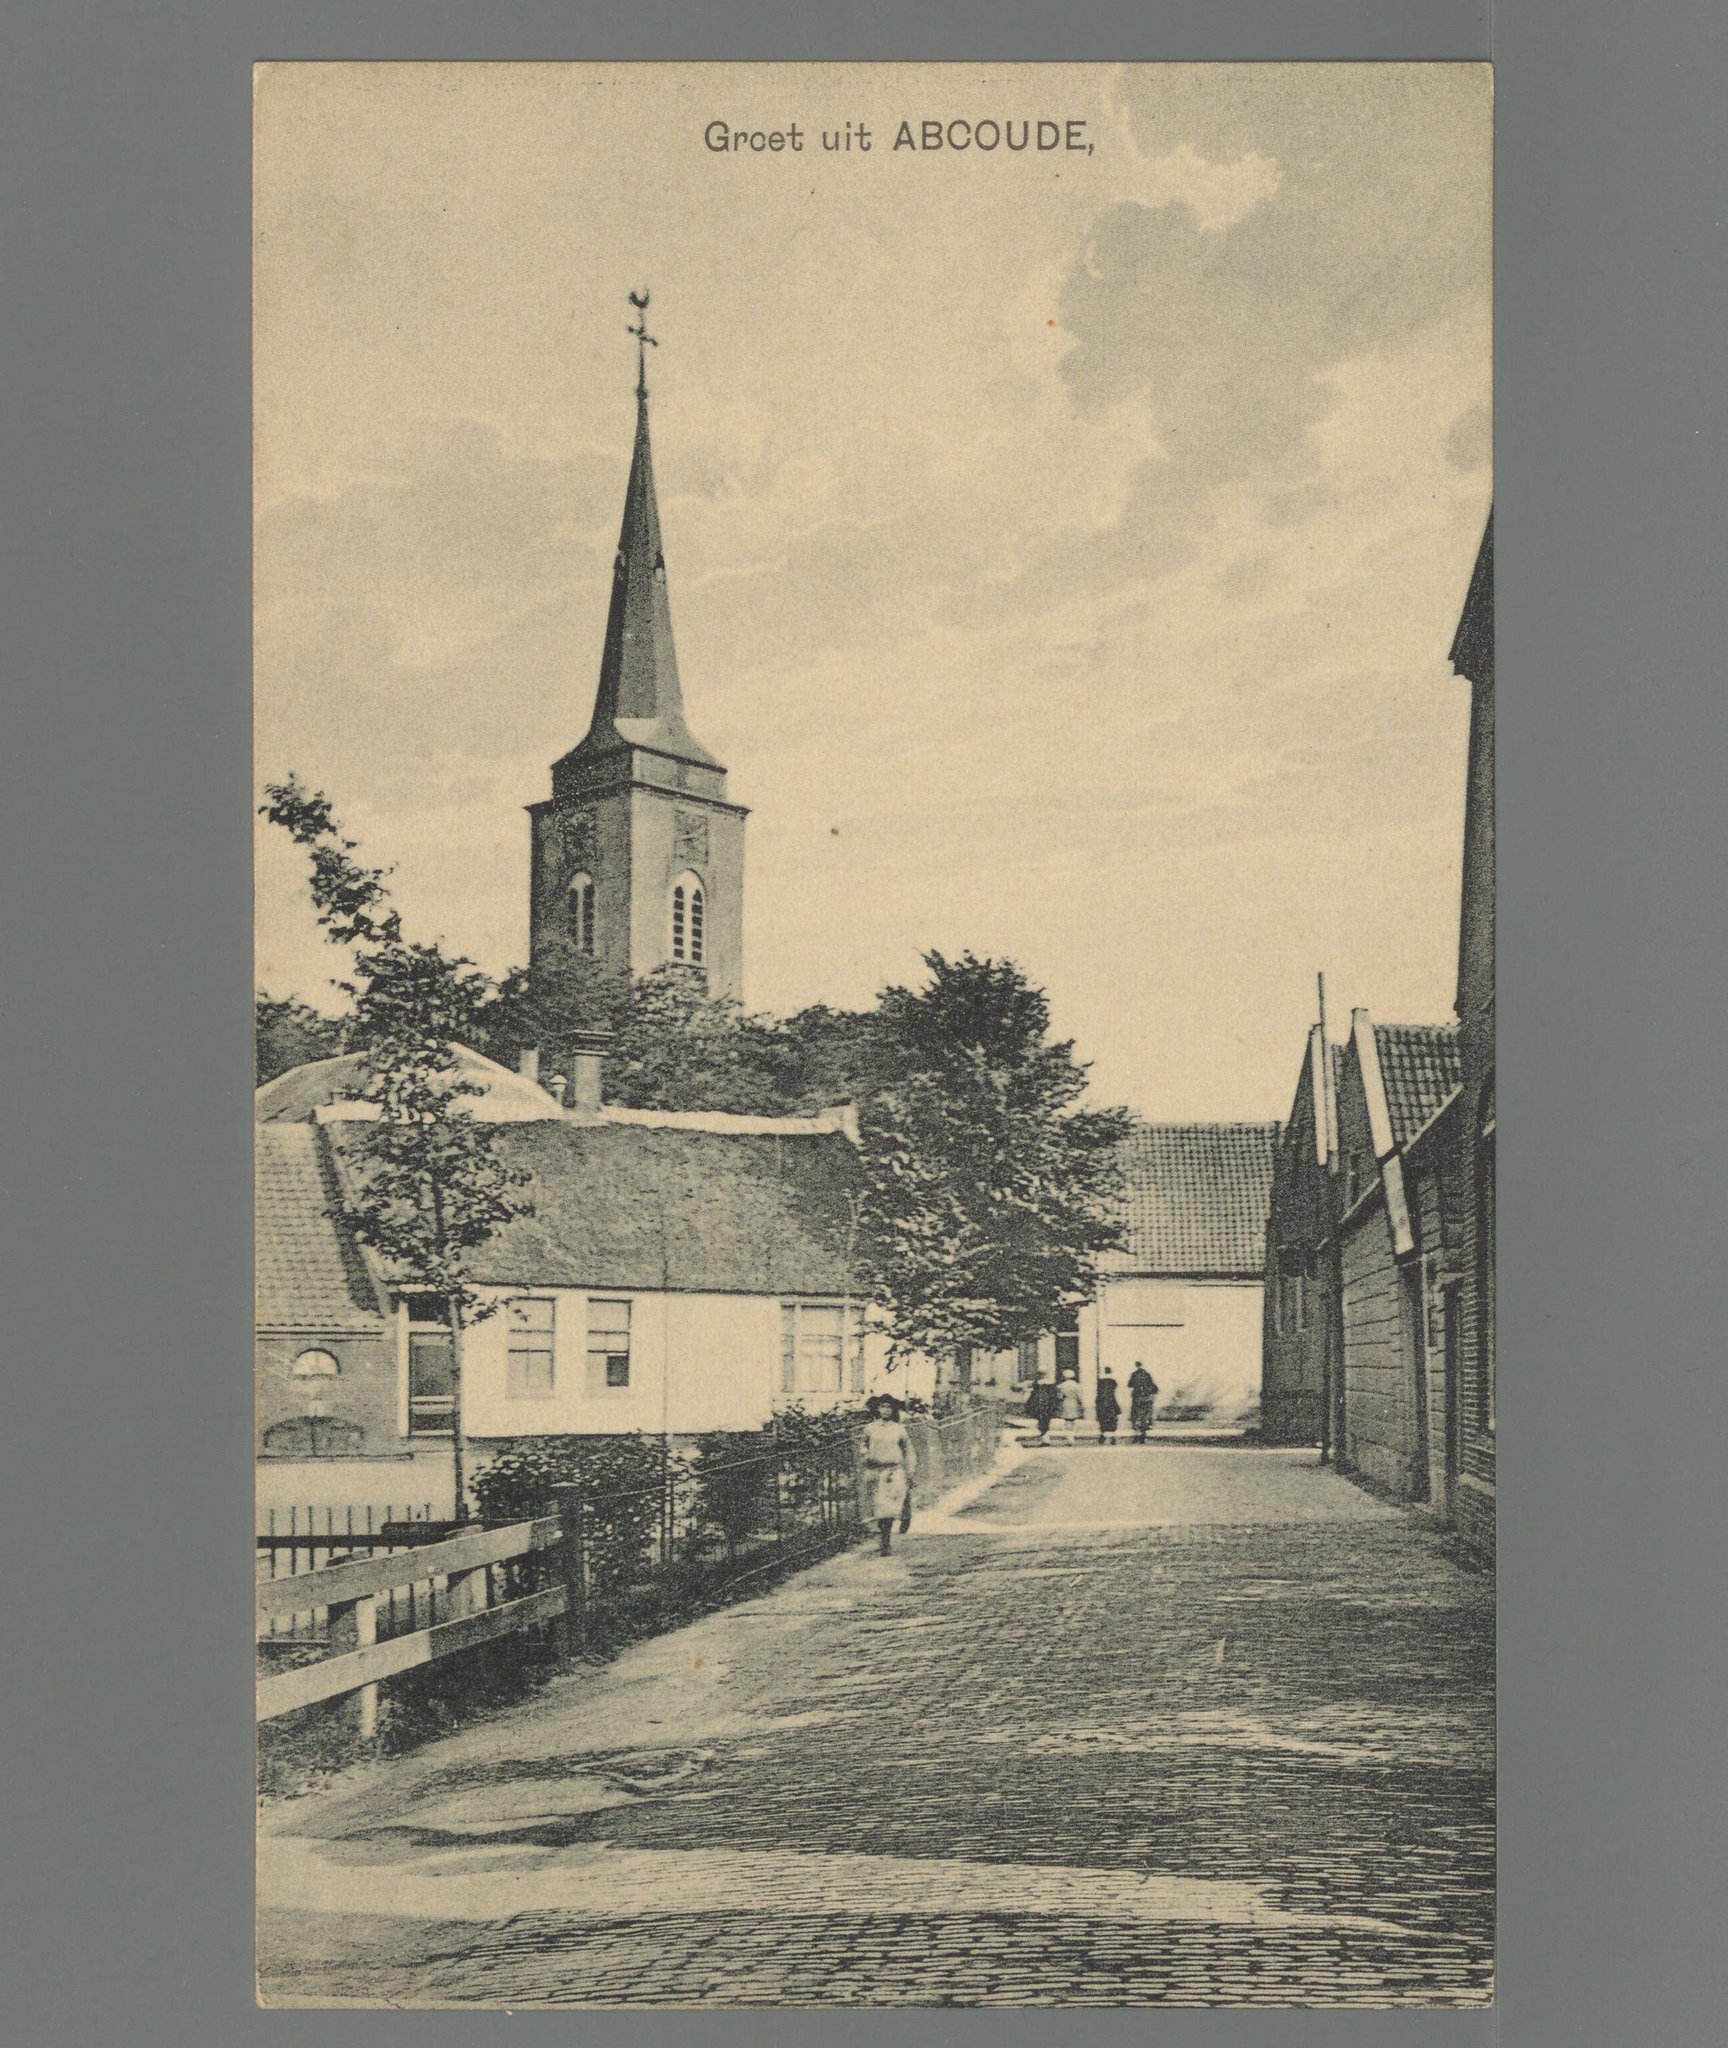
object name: photomechanical print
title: Groet uit ABCOUDE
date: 1906-1926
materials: cardboard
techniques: photograph, writing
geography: velsen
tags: city-view, and landscape with man-made constructions, church (exterior), abcoude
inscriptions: postage stamp